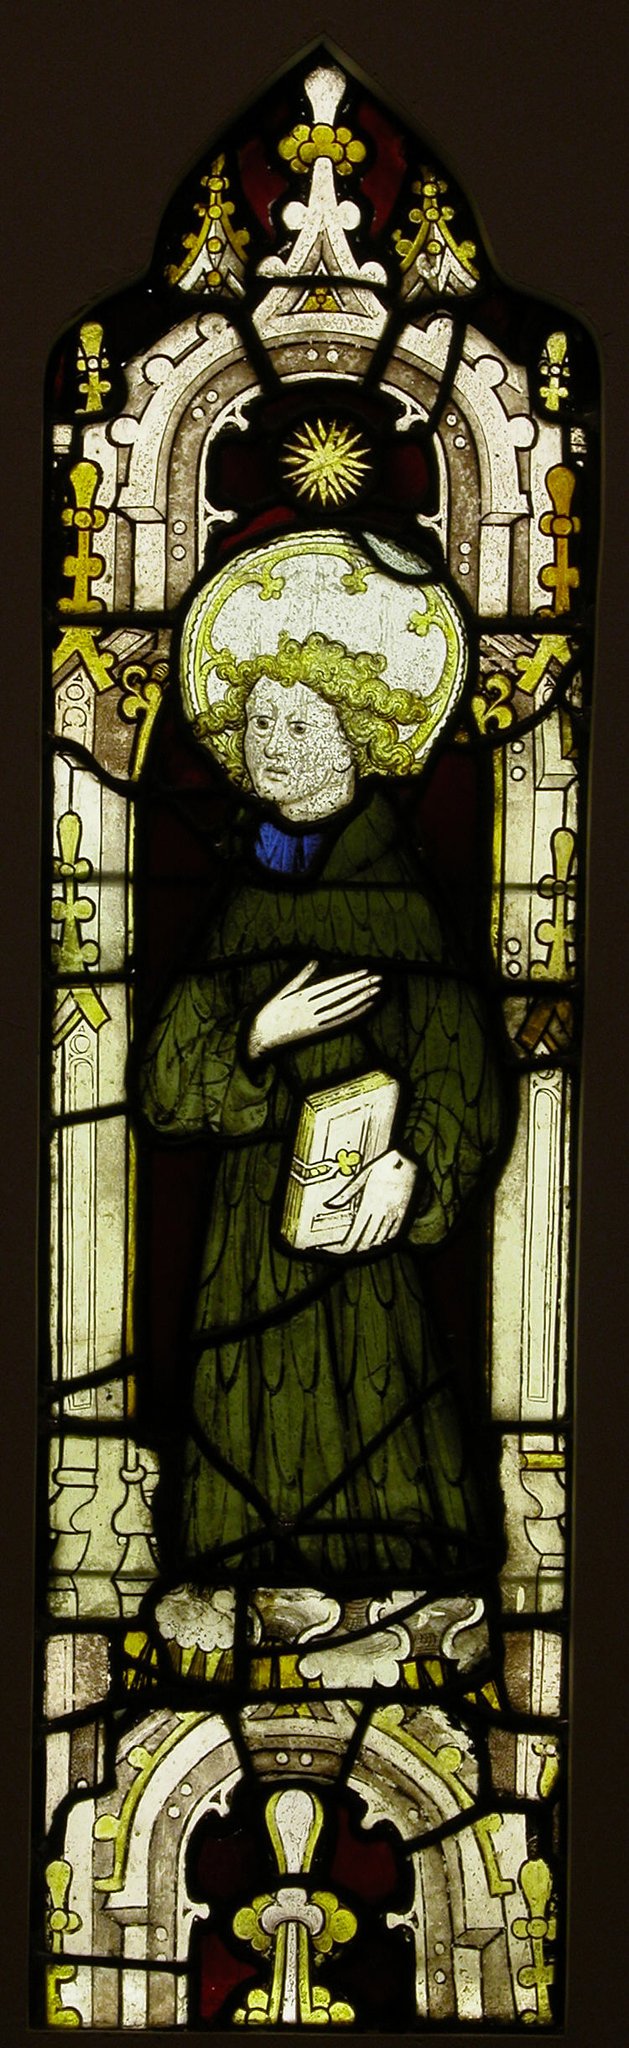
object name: panel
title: Figure of an Angel within a Composite Panel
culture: british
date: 1450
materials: glass, metal, paint, pigment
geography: england